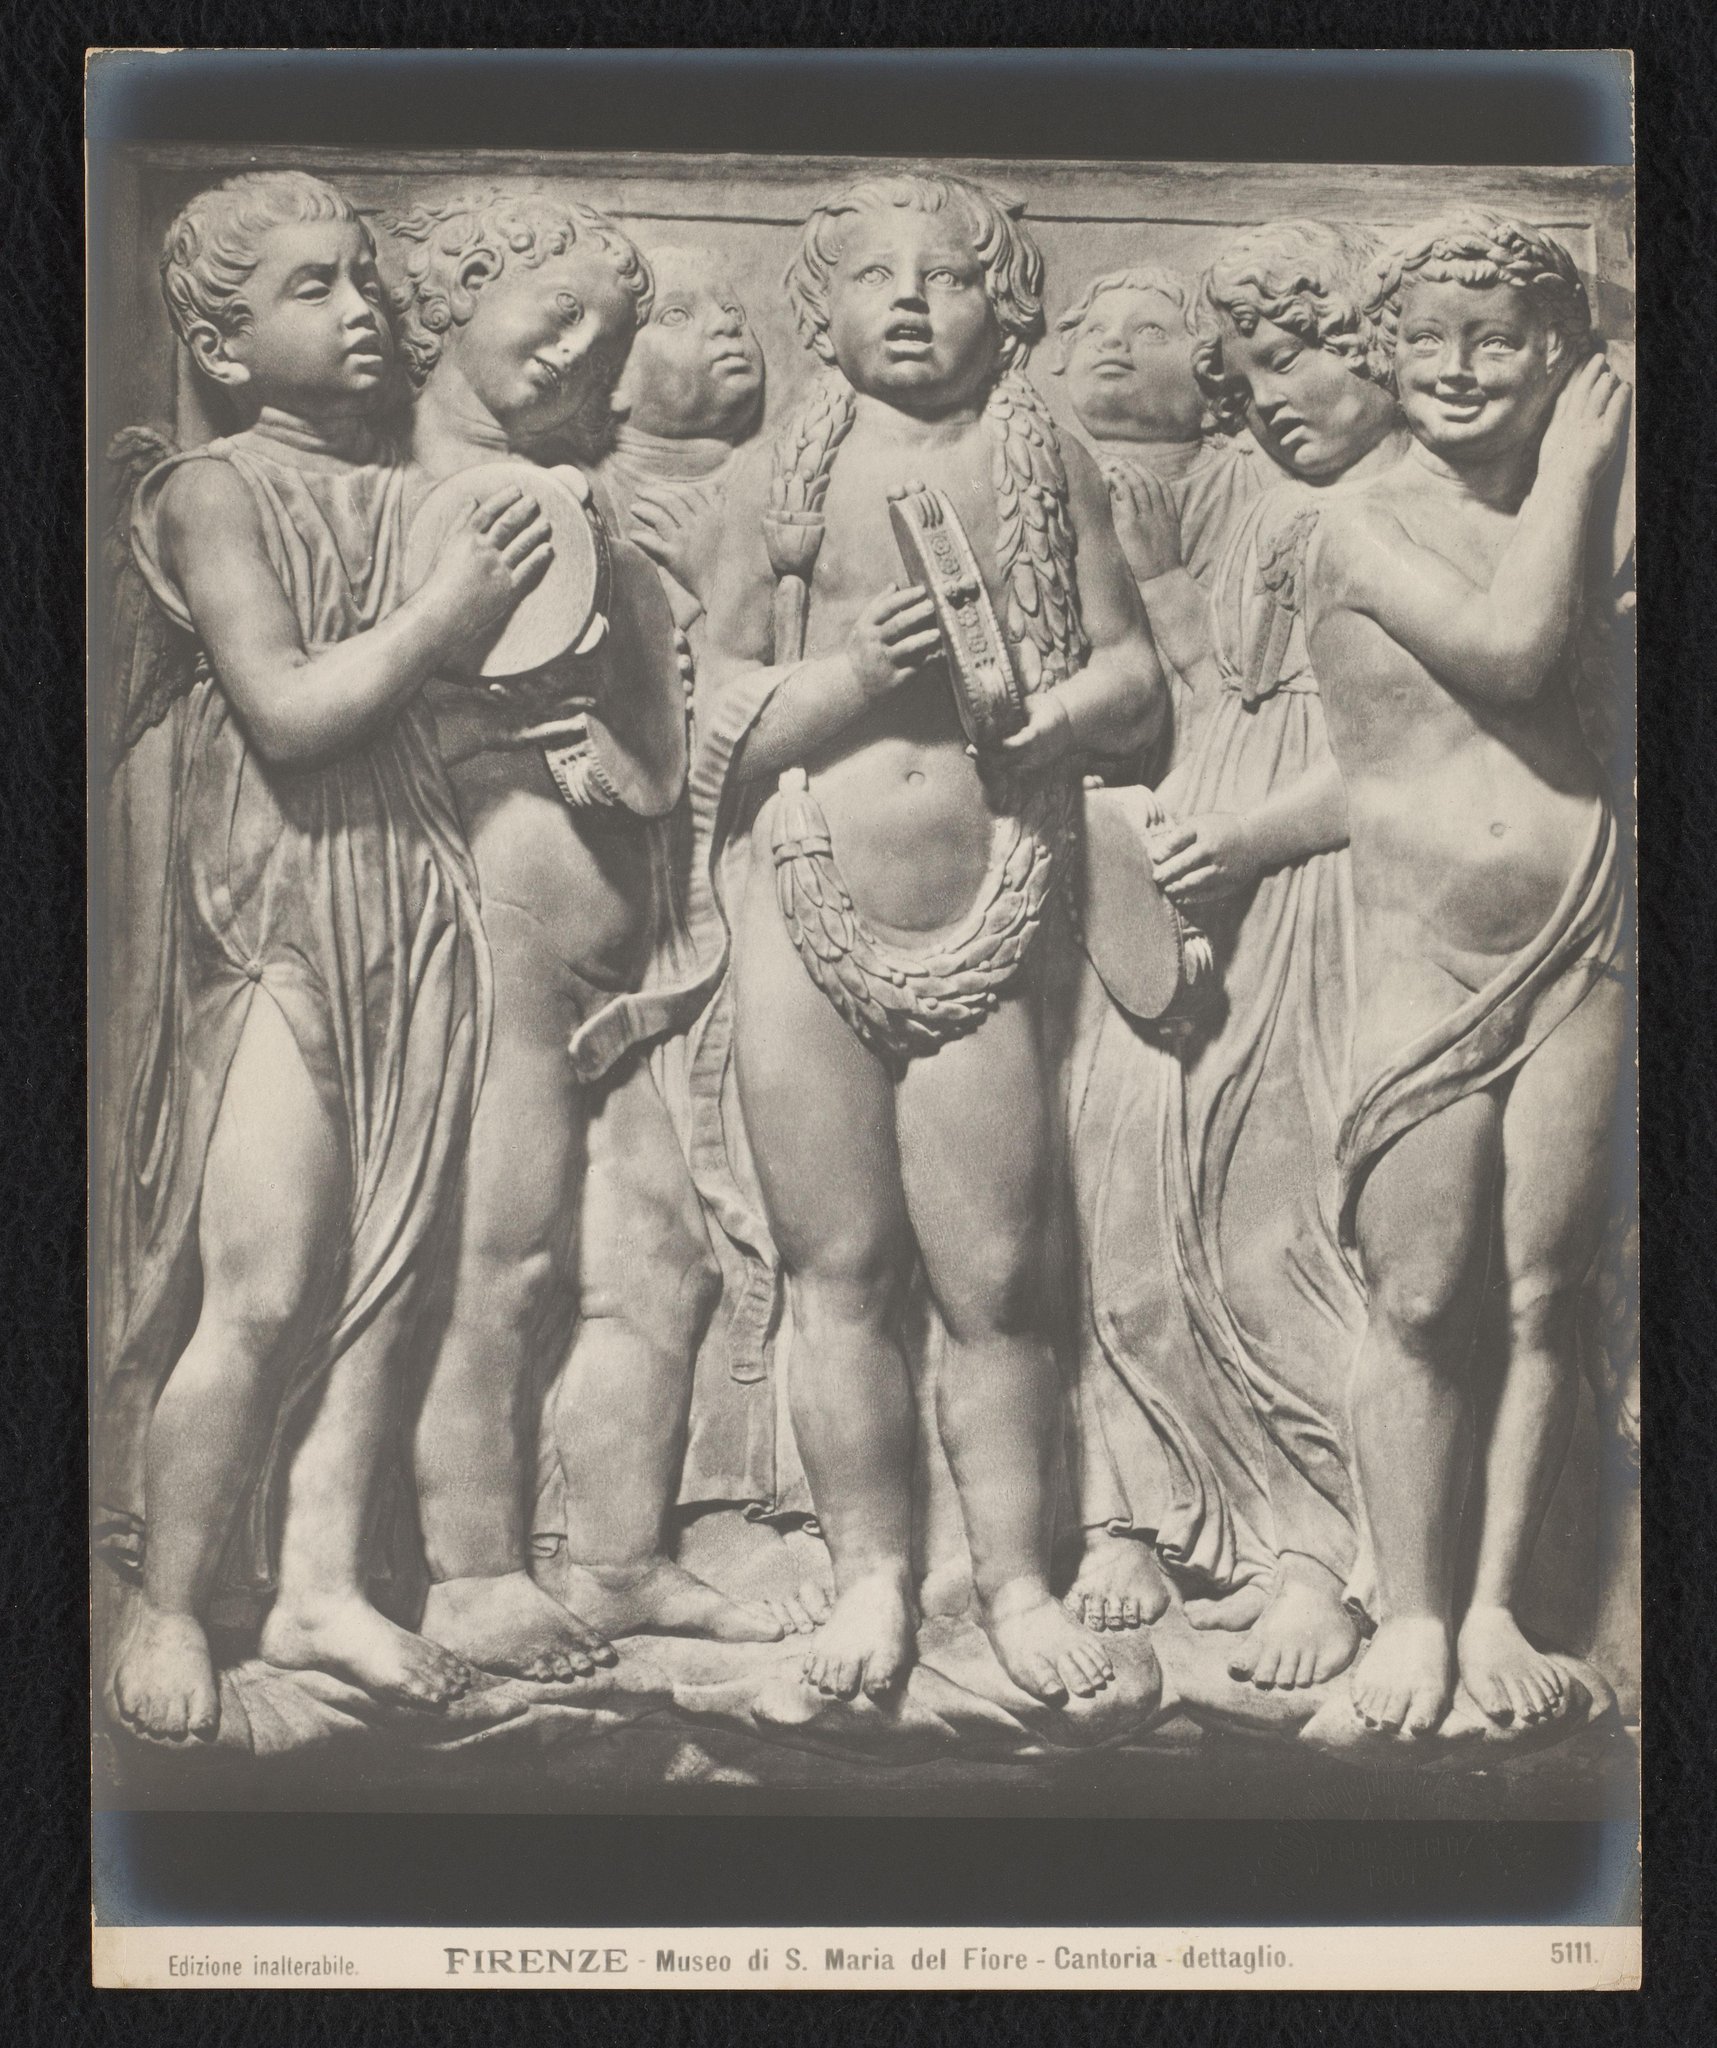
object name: photograph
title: Museo di S. Maria del Fiore - Cantoria - dettaglio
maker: Anonymous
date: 1900-1920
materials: paper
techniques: gelatin silver print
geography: florence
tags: art (+ relief ~ sculpture)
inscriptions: number: ‘5111.’, collector's mark: ‘RIJKS SCHOOL VOOR KUNSTNIJVERHEID/ GROEP’, inscription: ‘Edizione inalterabile.’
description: Deze foto maakt deel uit van een omslag.